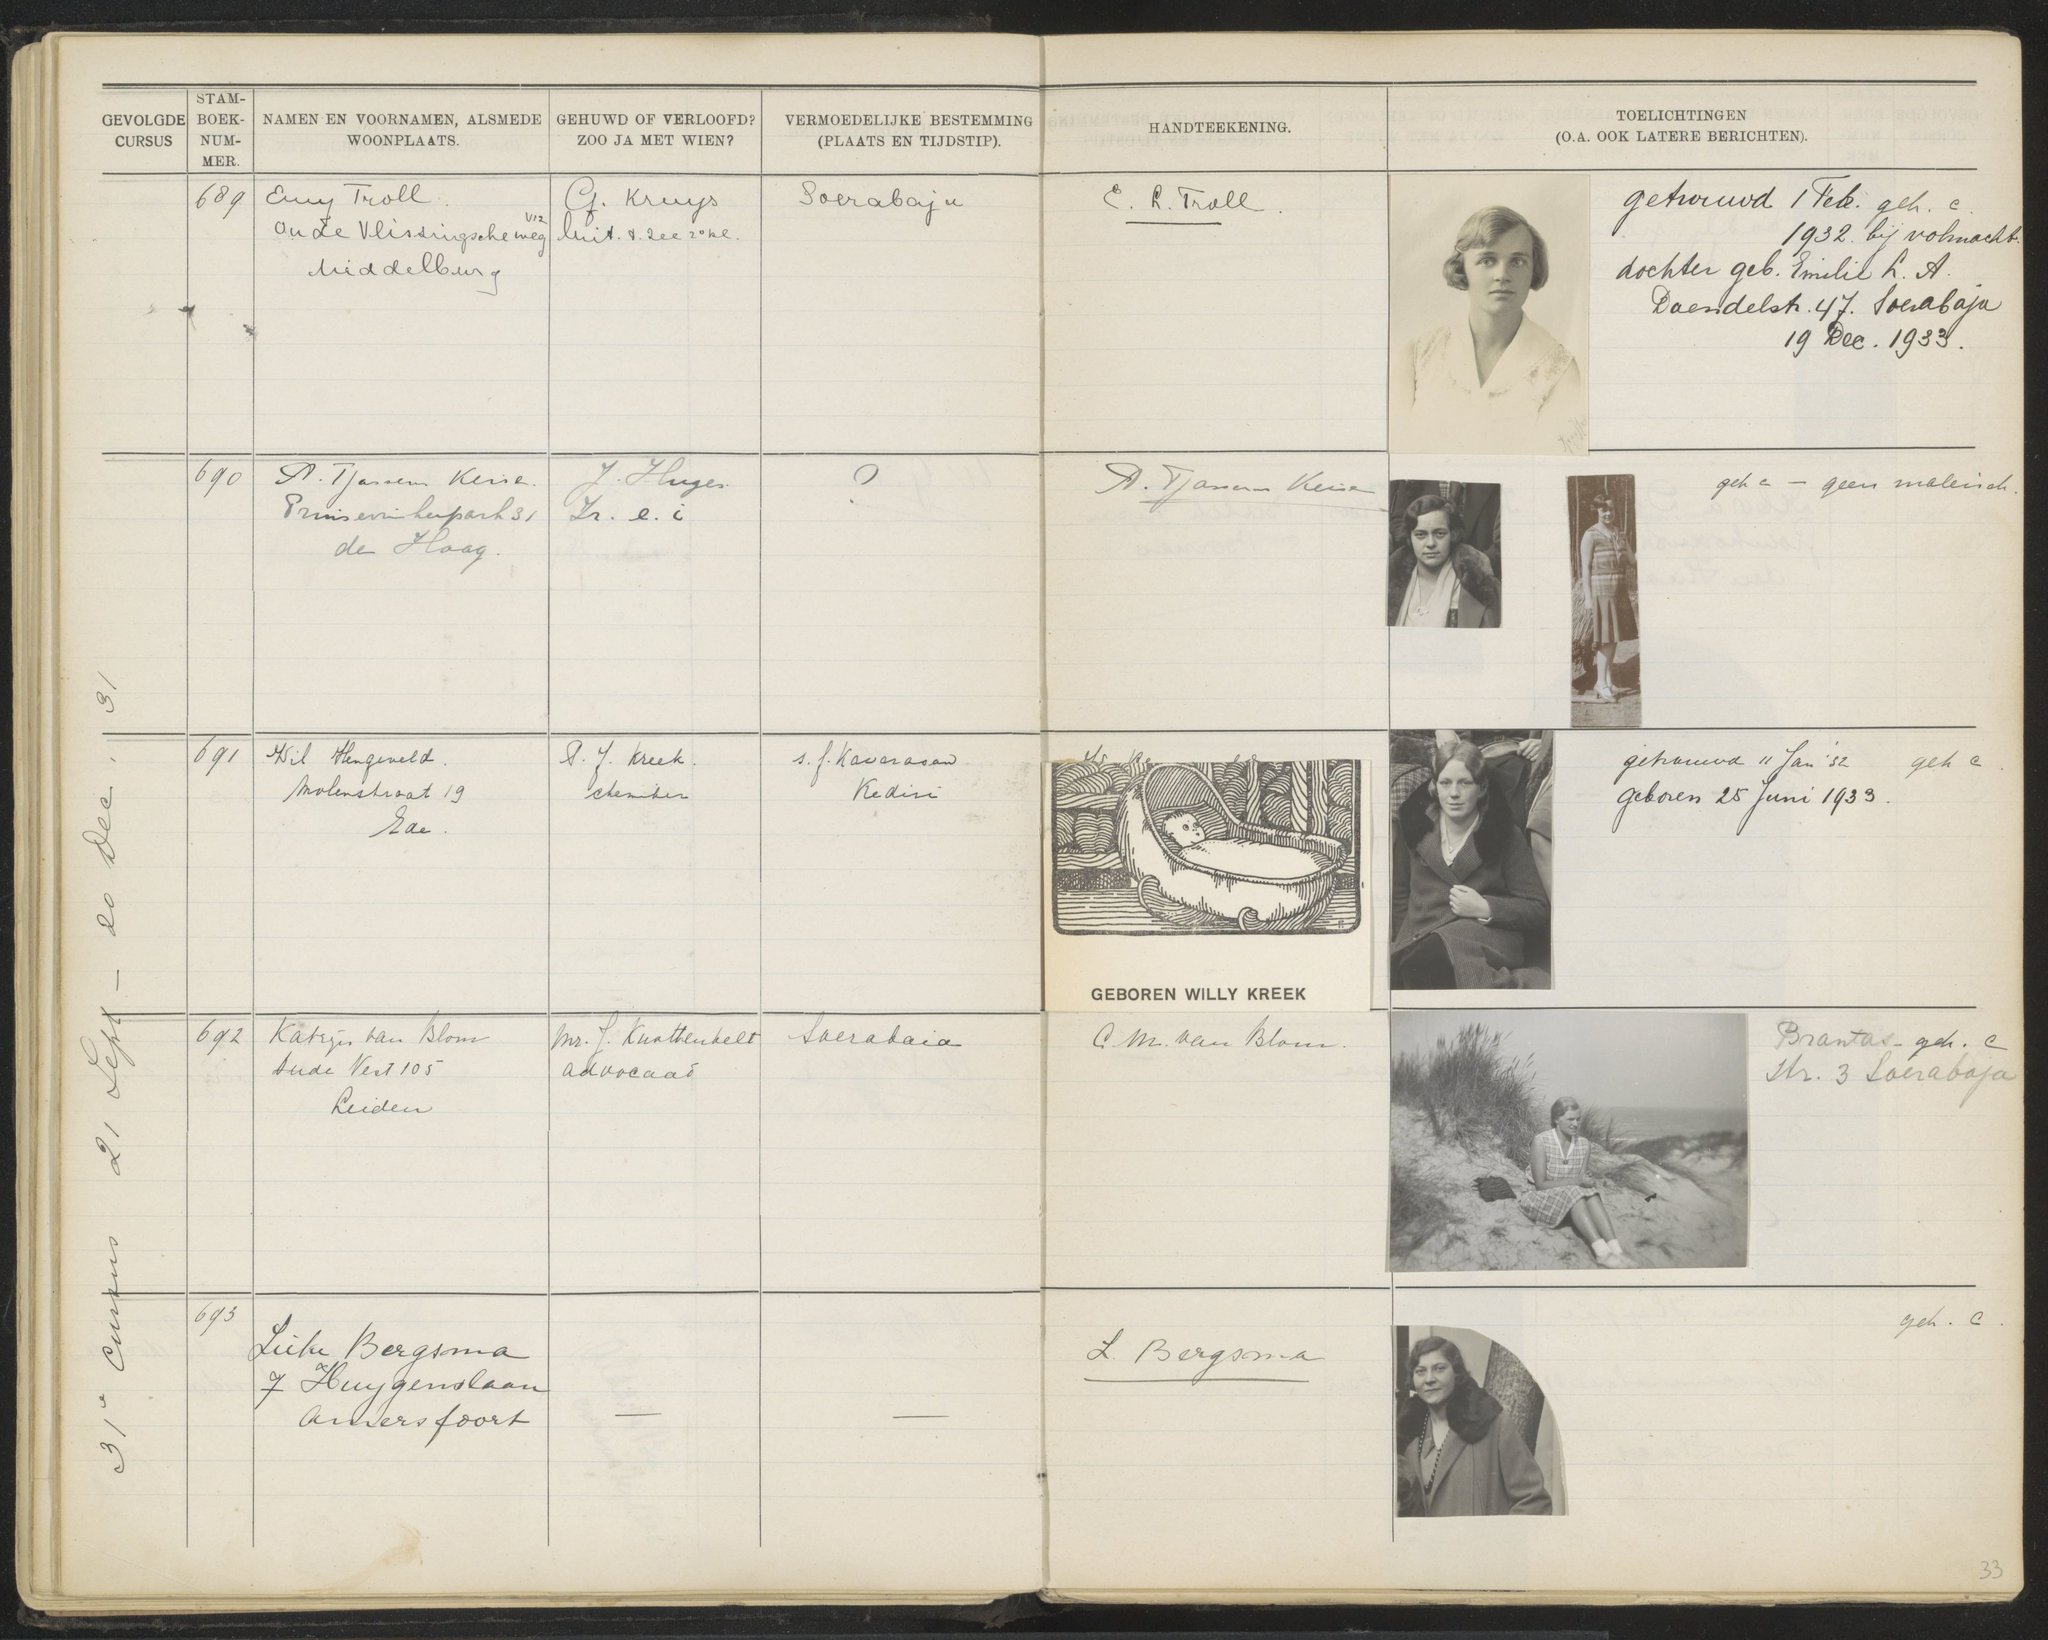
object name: photograph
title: Blad 33 uit Stamboek van de leerlingen der Koloniale School voor Meisjes en Vrouwen te 's-Gravenhage deel II (1930-1949)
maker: Anonymous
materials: paper, photographic support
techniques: photography, printing, writing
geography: the hague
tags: further education (+ pupil), further education, the hague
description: Twee pagina's met gegevens van de deelnemers aan de 31e driemaandelijkse cursus van 21 september tot en met 20 december 1931, stamboeknummers 689 tot en met 693. Onderdeel van Stamboek van de leerlingen der Koloniale School voor Meisjes en Vrouwen te 's-Gravenhage deel II (1930-1949).